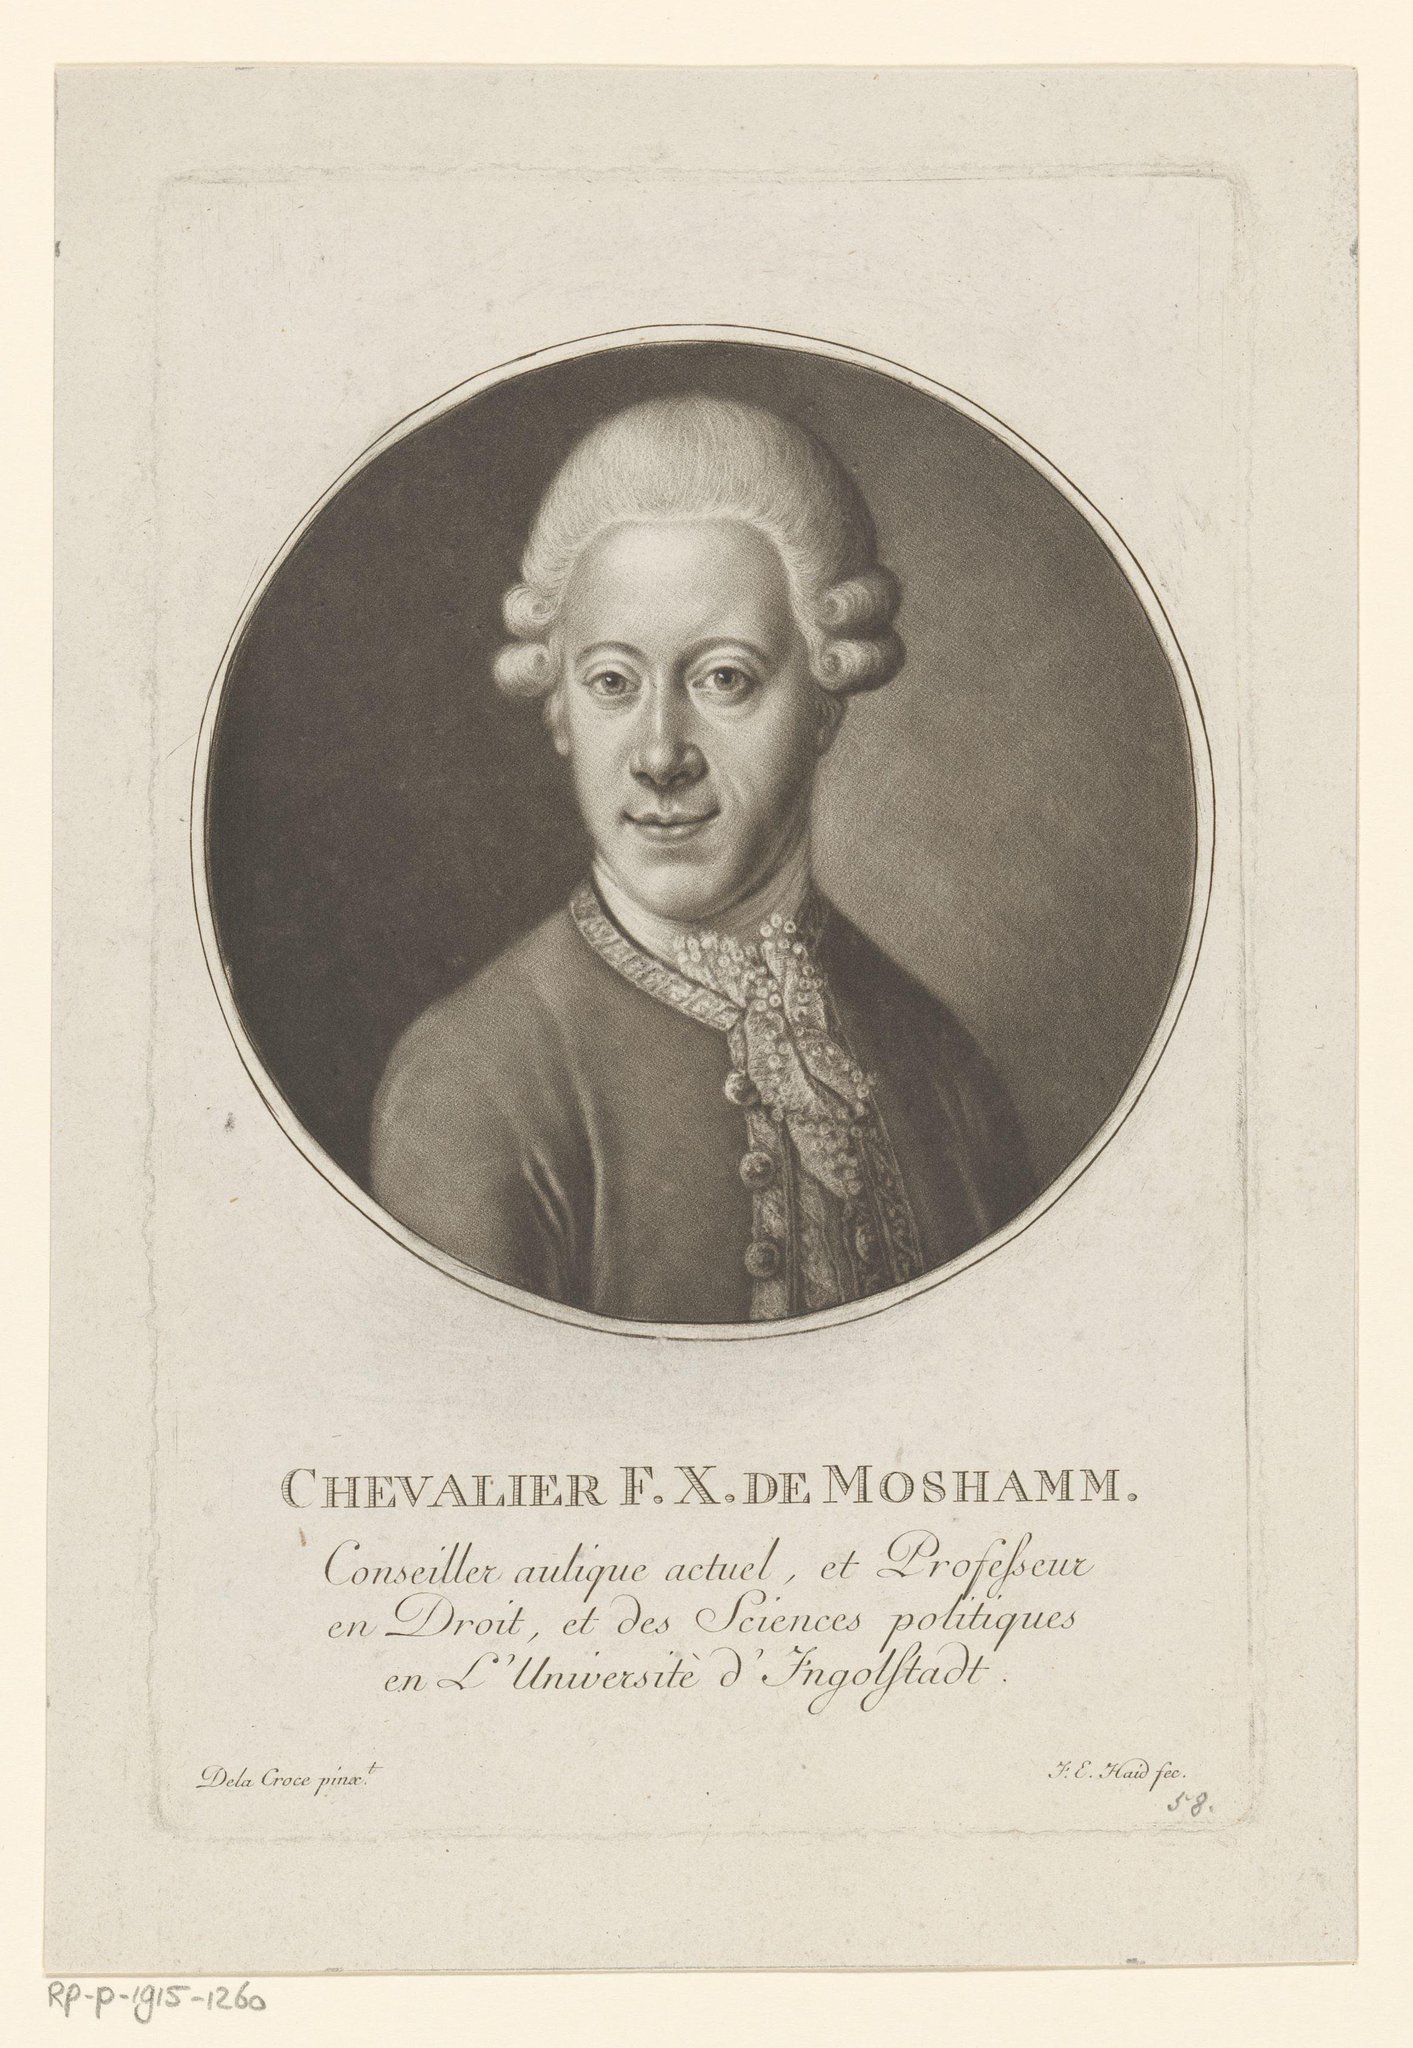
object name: print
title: Portret van Franz Xaver von Moshammer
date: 1766-1809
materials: paper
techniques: mezzotint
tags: historical persons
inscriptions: collector's mark: Lugt 2228